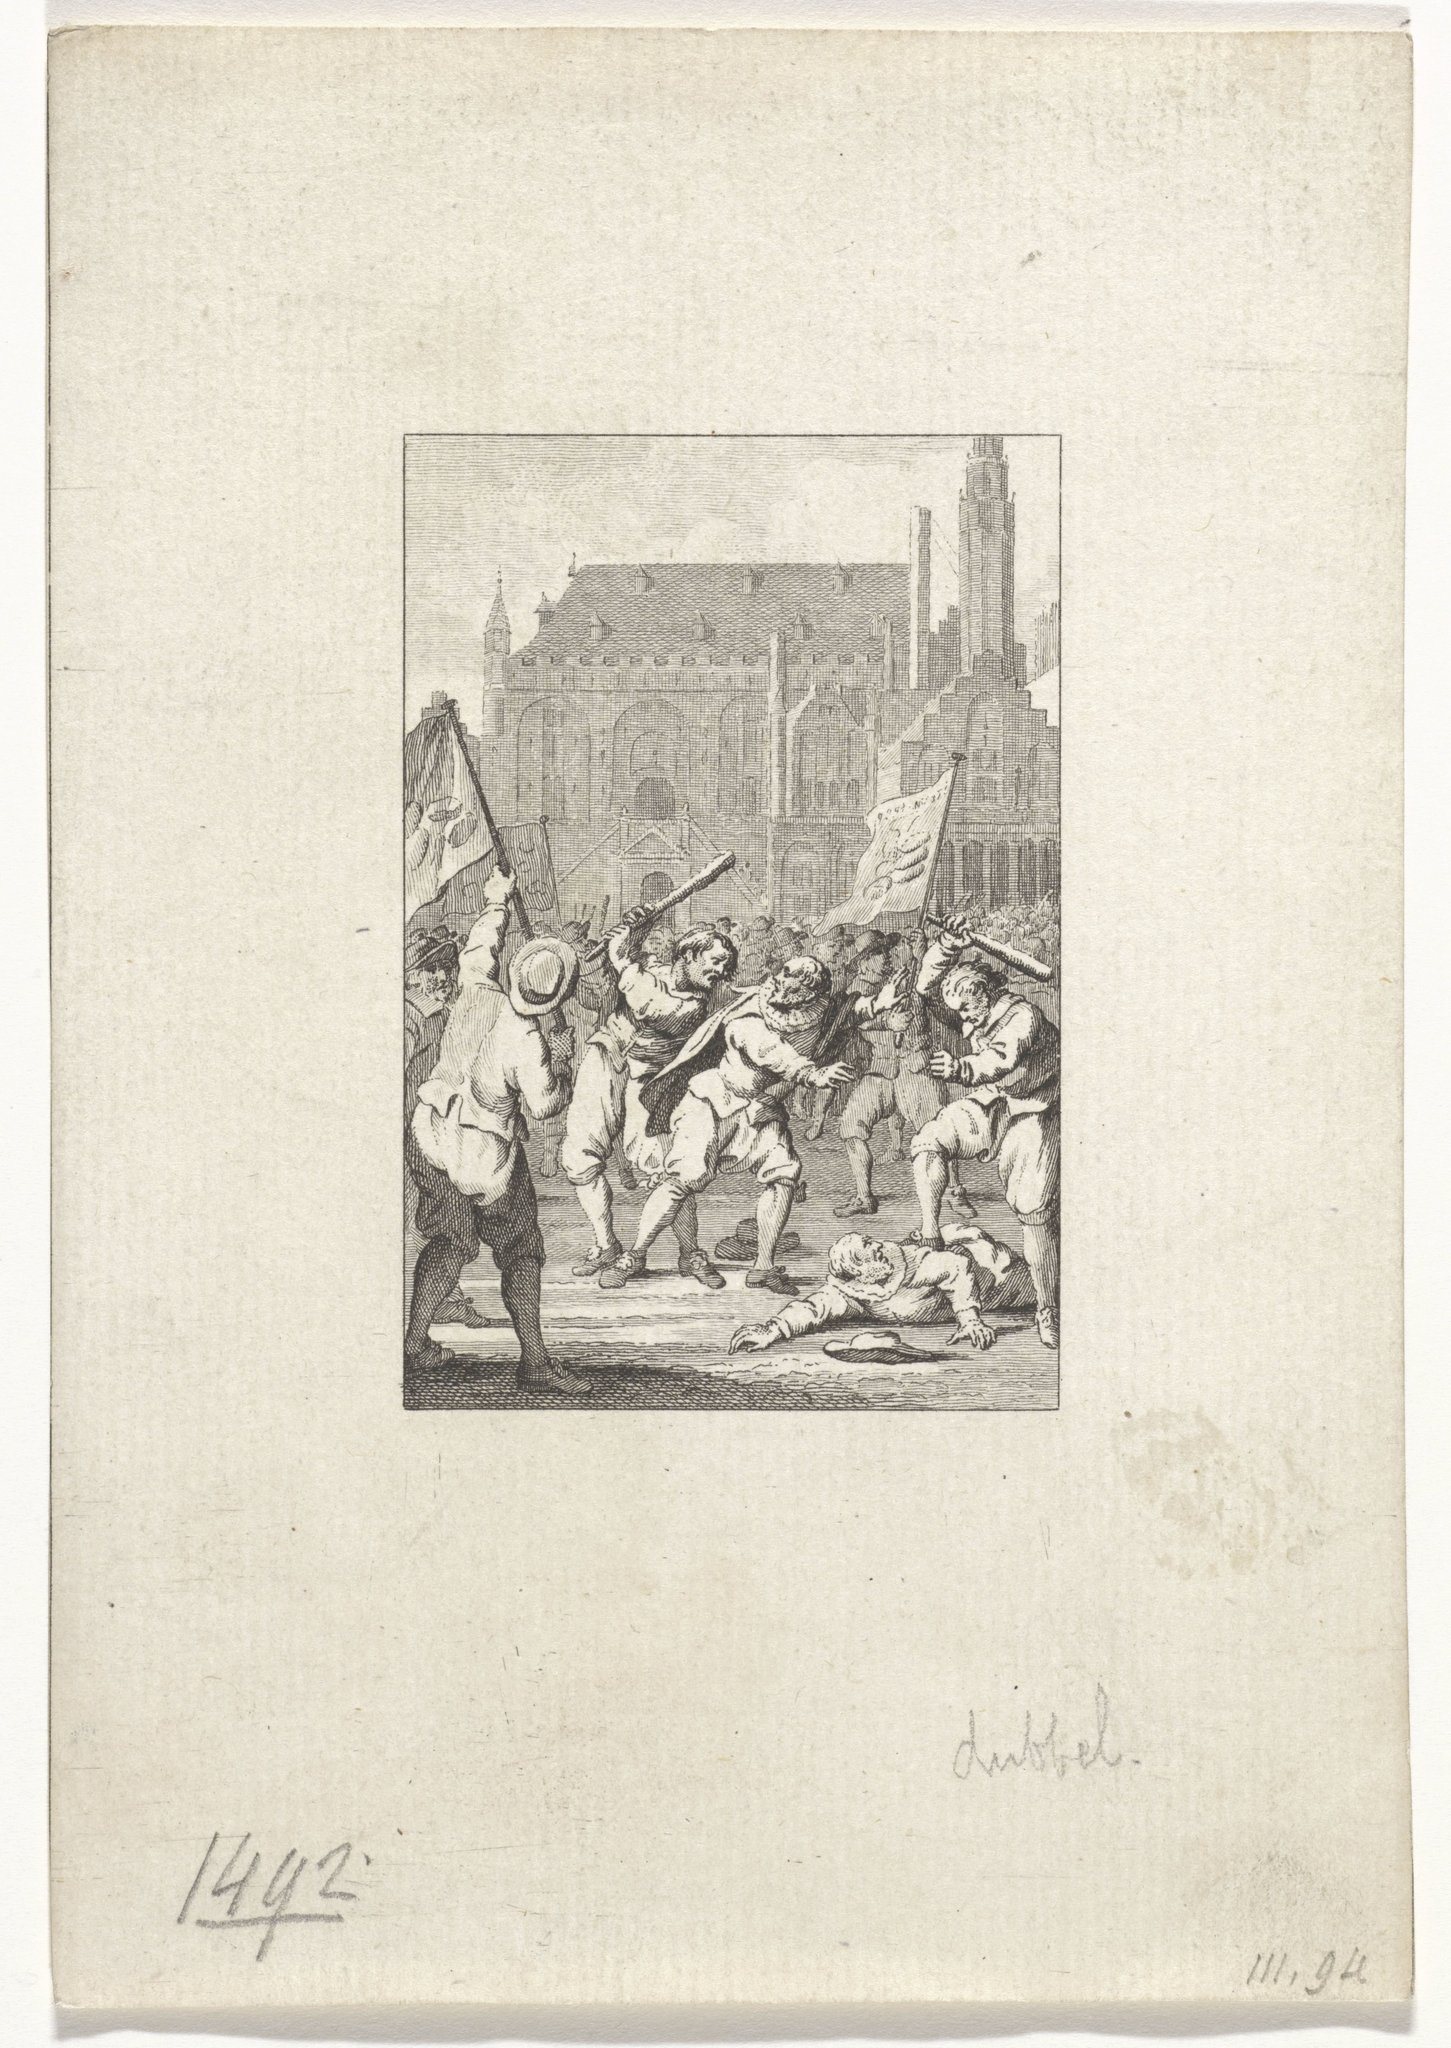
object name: history print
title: Opstand van het Kaas- en Broodvolk en moord op Claes van Ruyven te Haarlem, 1492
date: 1783-1795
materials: paper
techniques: etching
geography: amsterdam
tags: haarlem, violent death, being killed; being mishandled and maltreated; seeking death, street-fights, riots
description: Illustratie voor: J. Fokke. Geschiedenissen der Vereenigde Nederlanden voor de vaderlandsche jeugd. Amsterdam: Johannes Allart, 1783-1795, 25 delen. deel III pl. II.